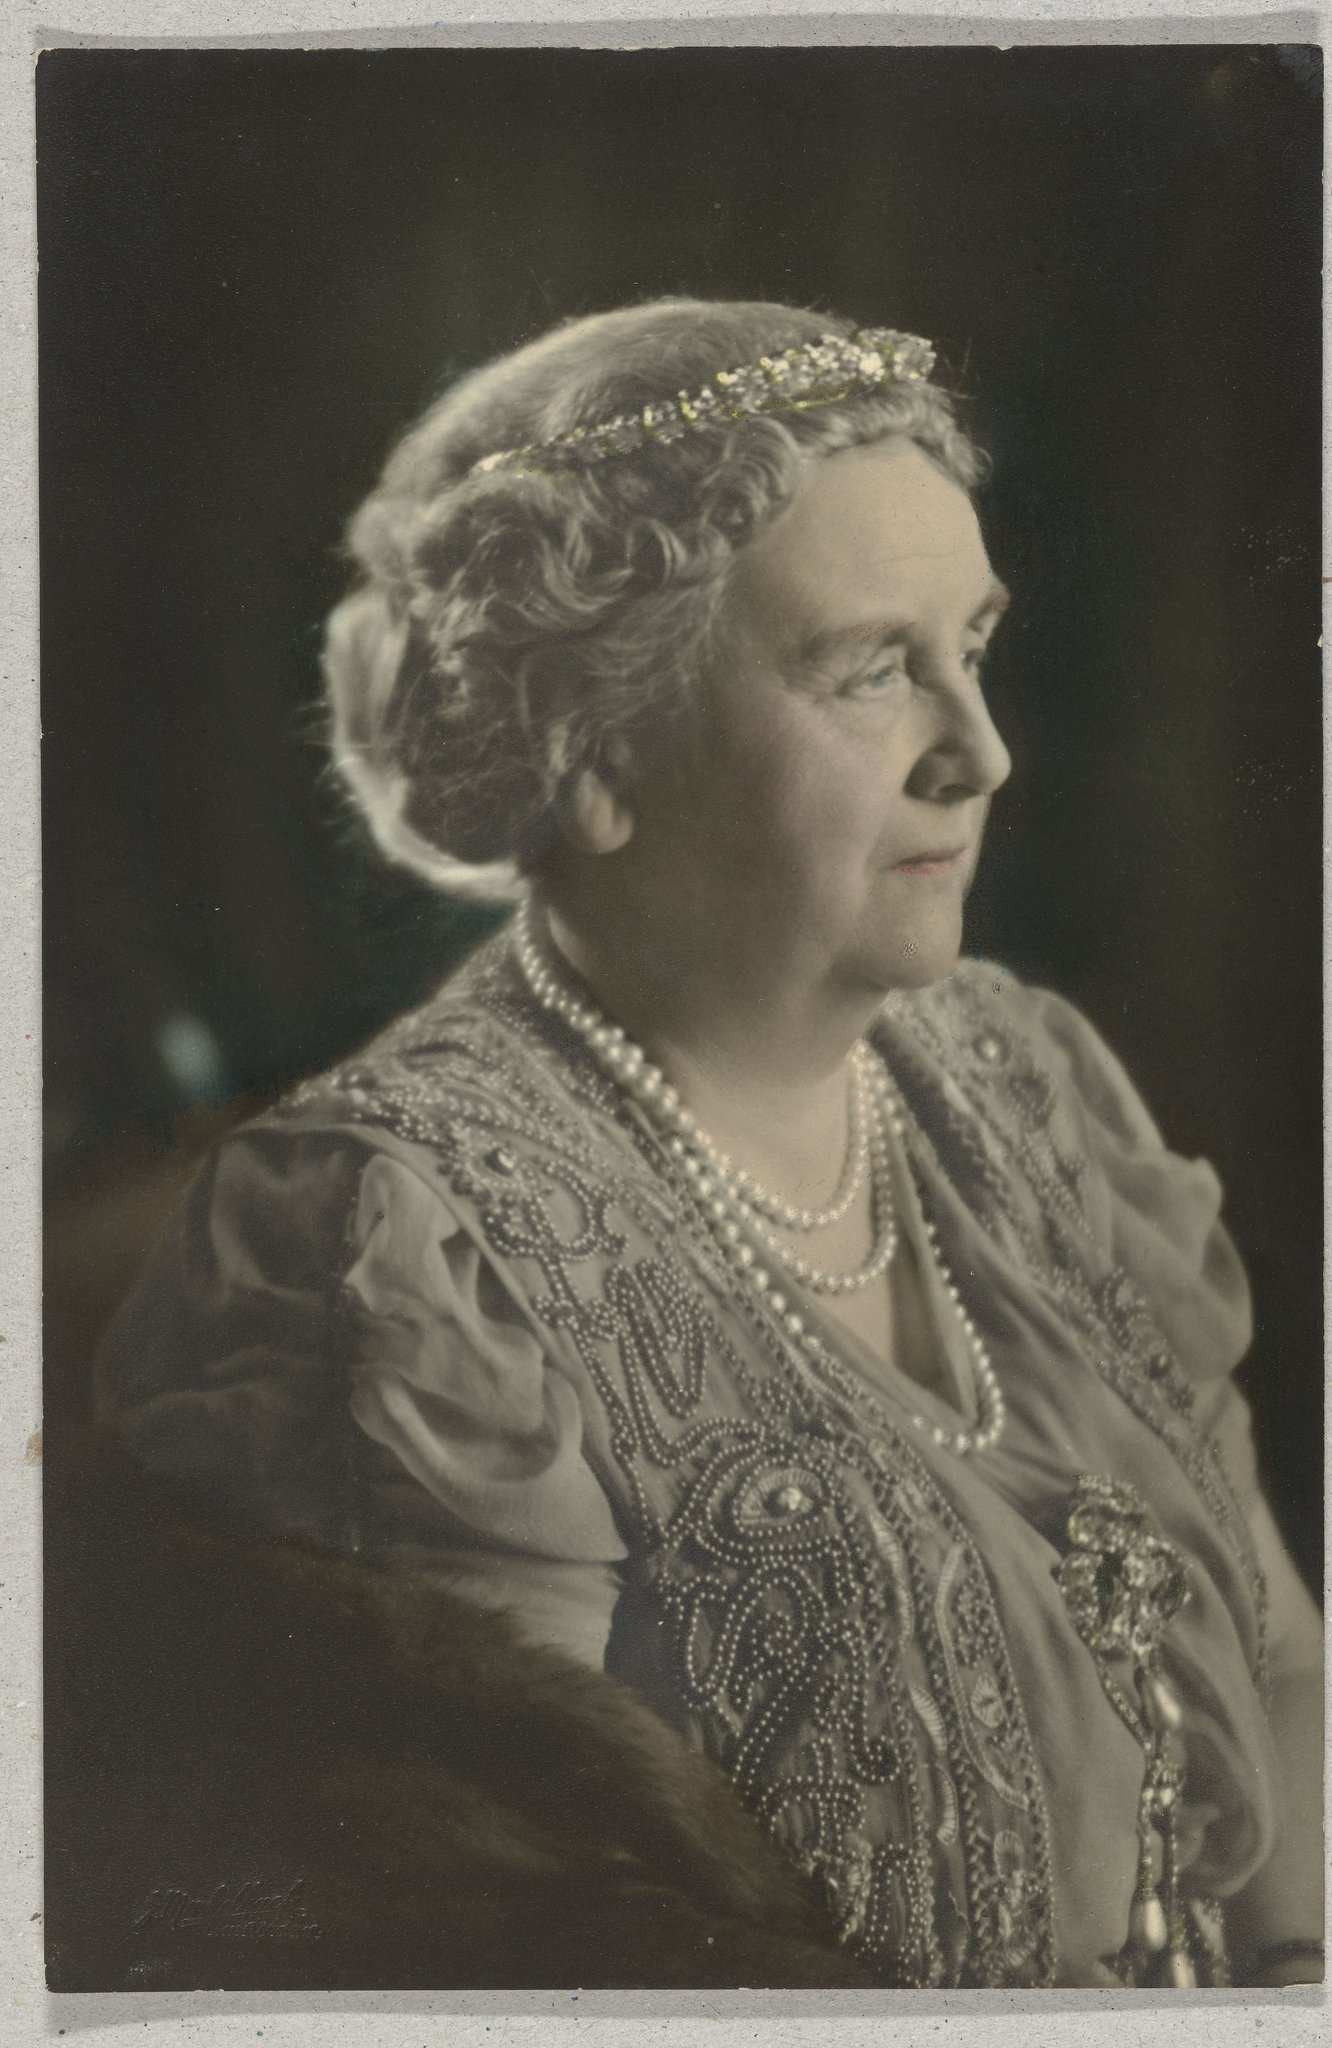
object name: photograph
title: Portret Koningin Wilhelmina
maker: jacob merkelbach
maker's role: fotograaf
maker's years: 1877-1942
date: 1948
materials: photographic support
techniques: gelatin silver print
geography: amsterdam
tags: the hague, print maker, wilhelmina of the netherlands